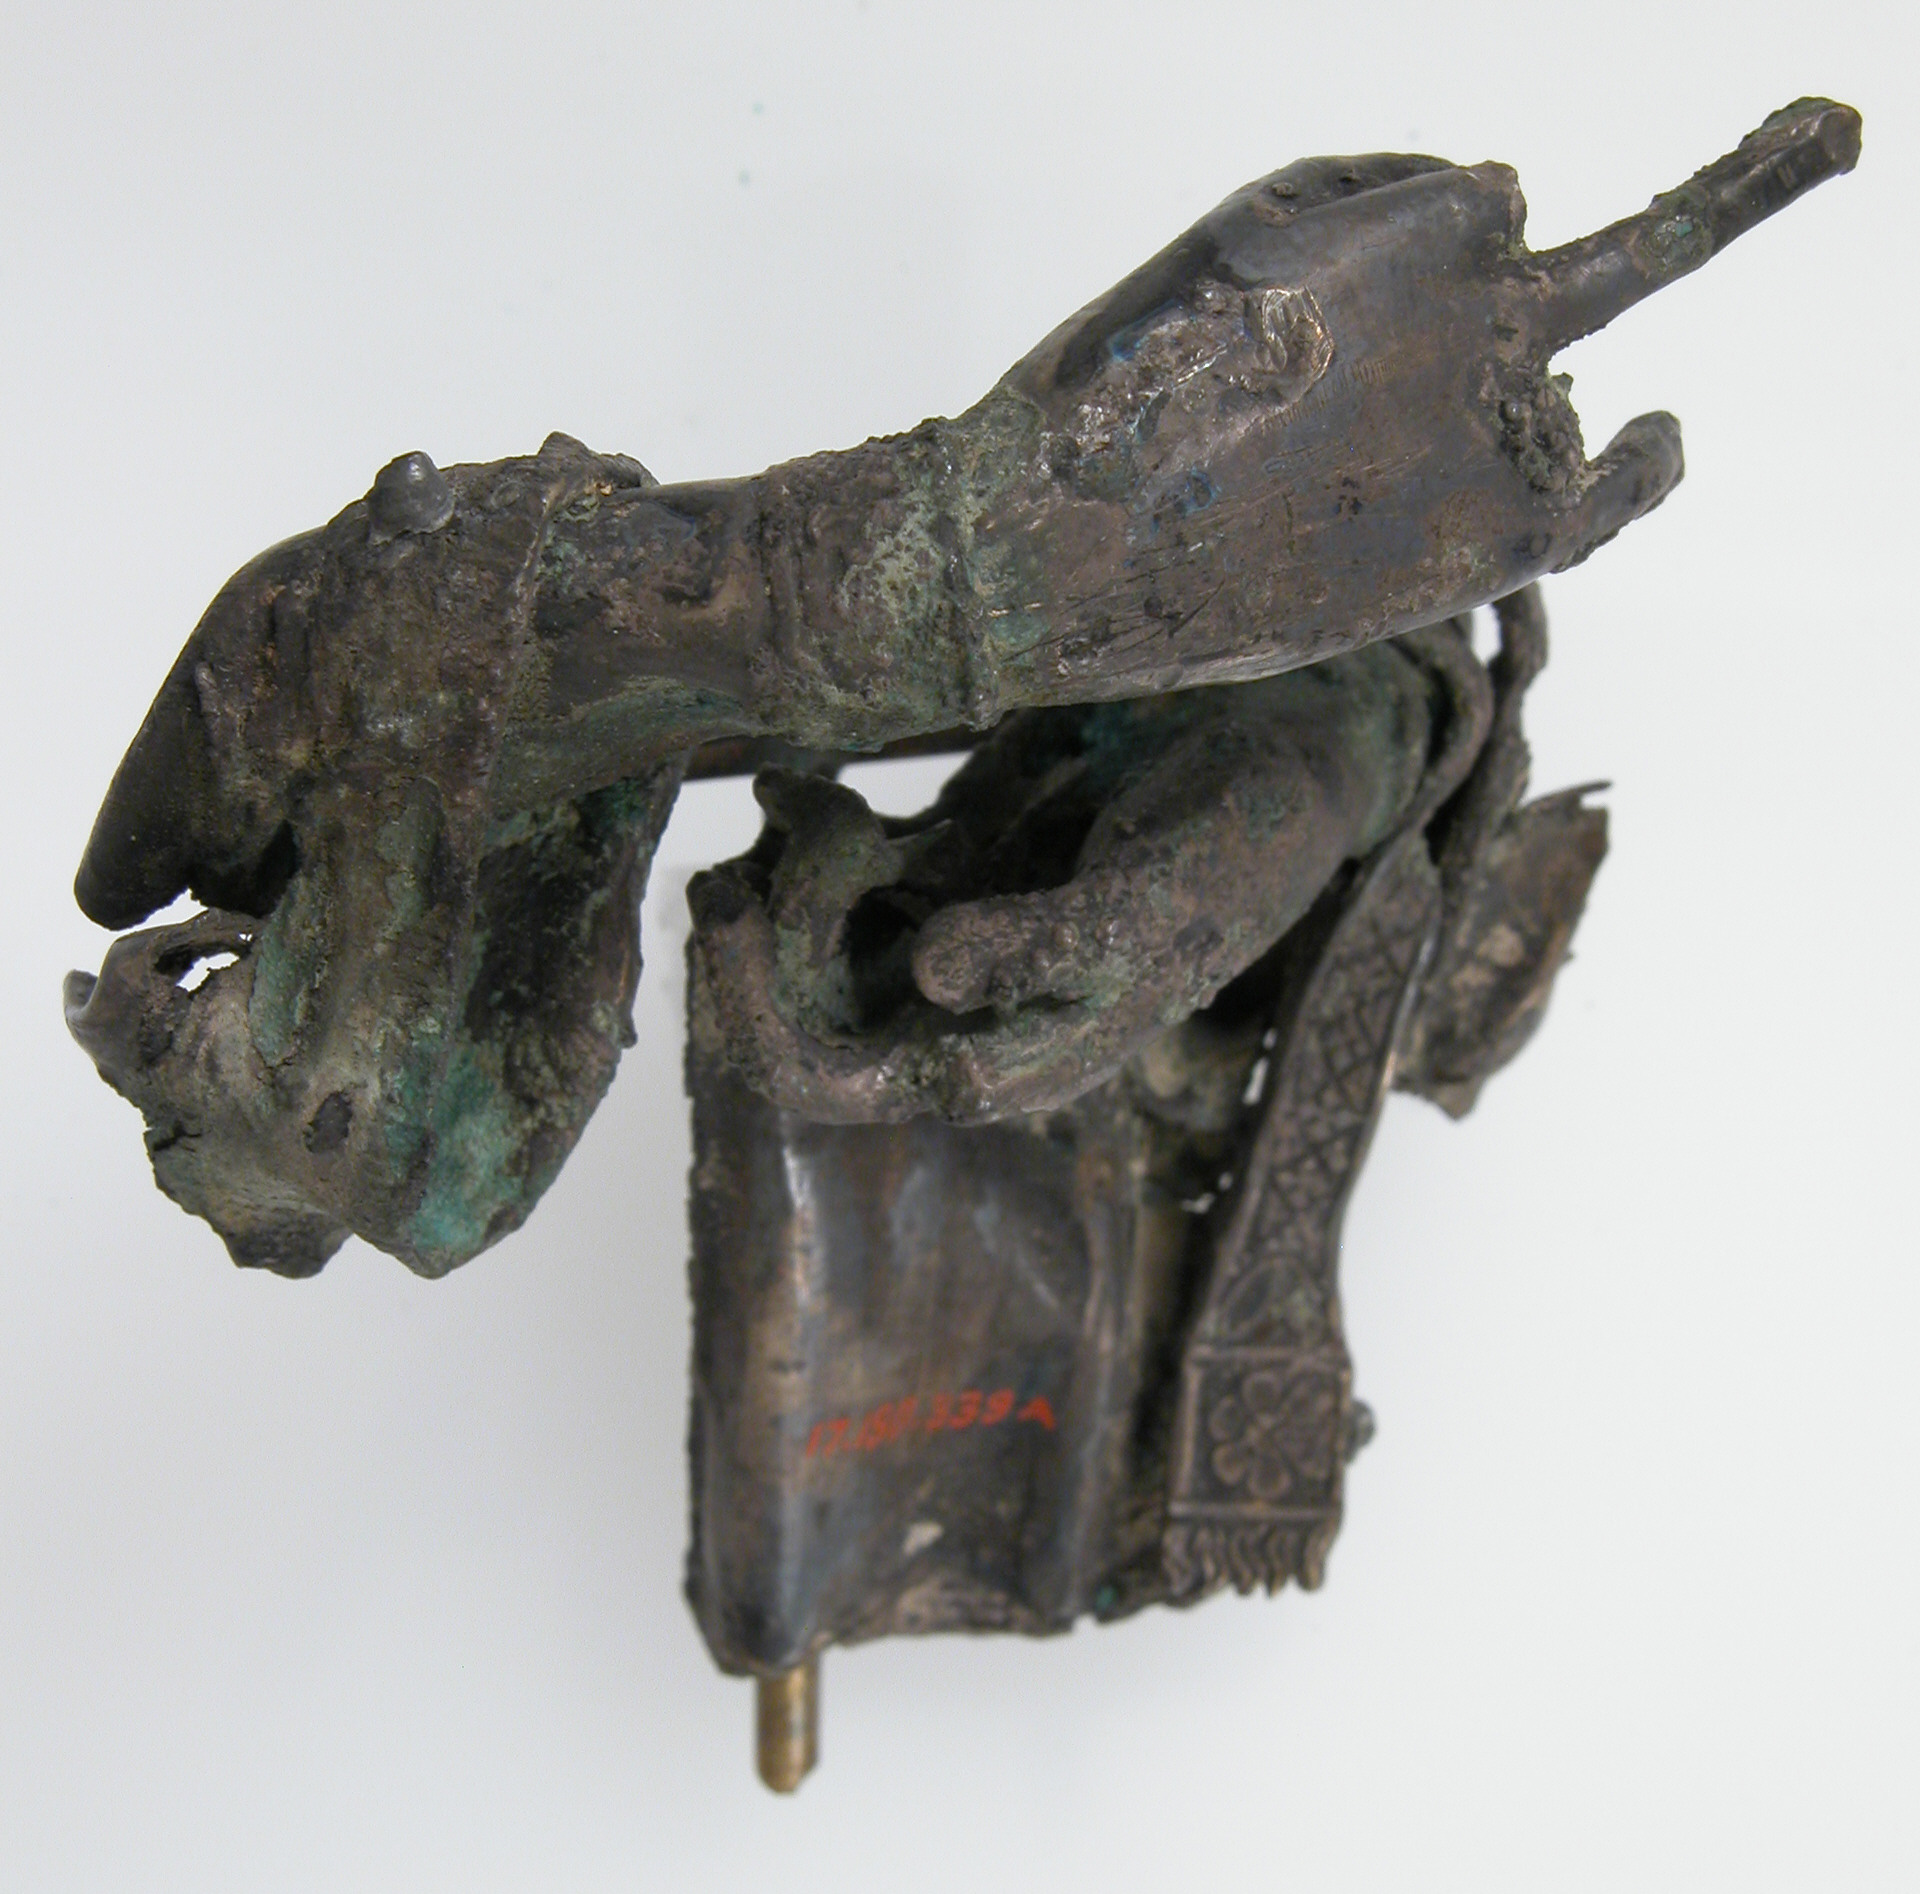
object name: statuette fragment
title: Two Fragments of Hands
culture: french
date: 1201-1300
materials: silver